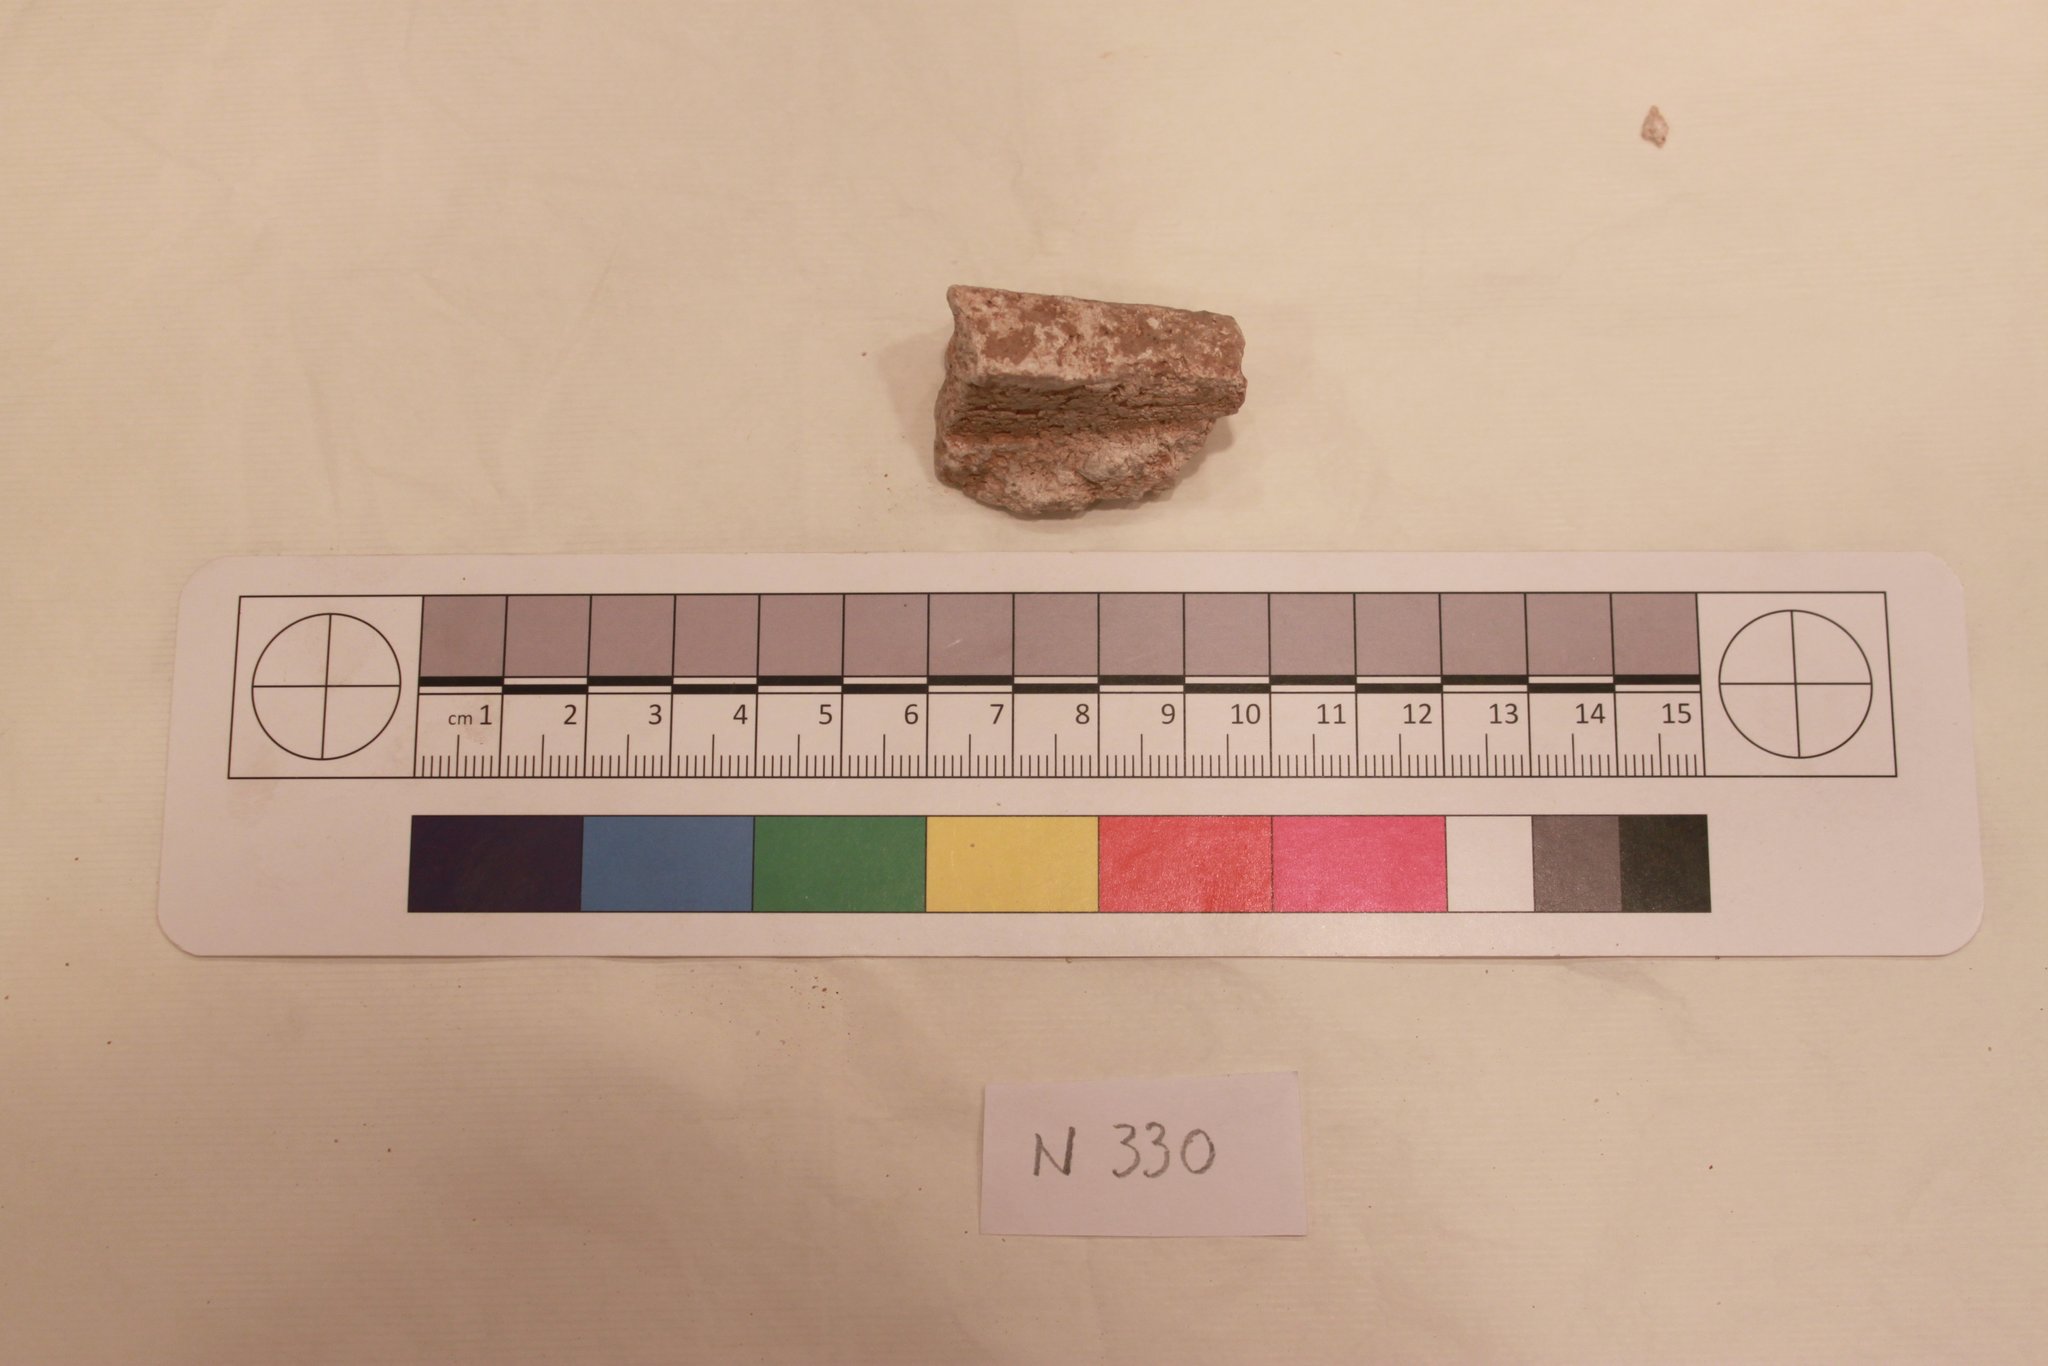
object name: fragment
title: Stucco Fragment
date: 701-1200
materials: plaster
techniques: carving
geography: iran